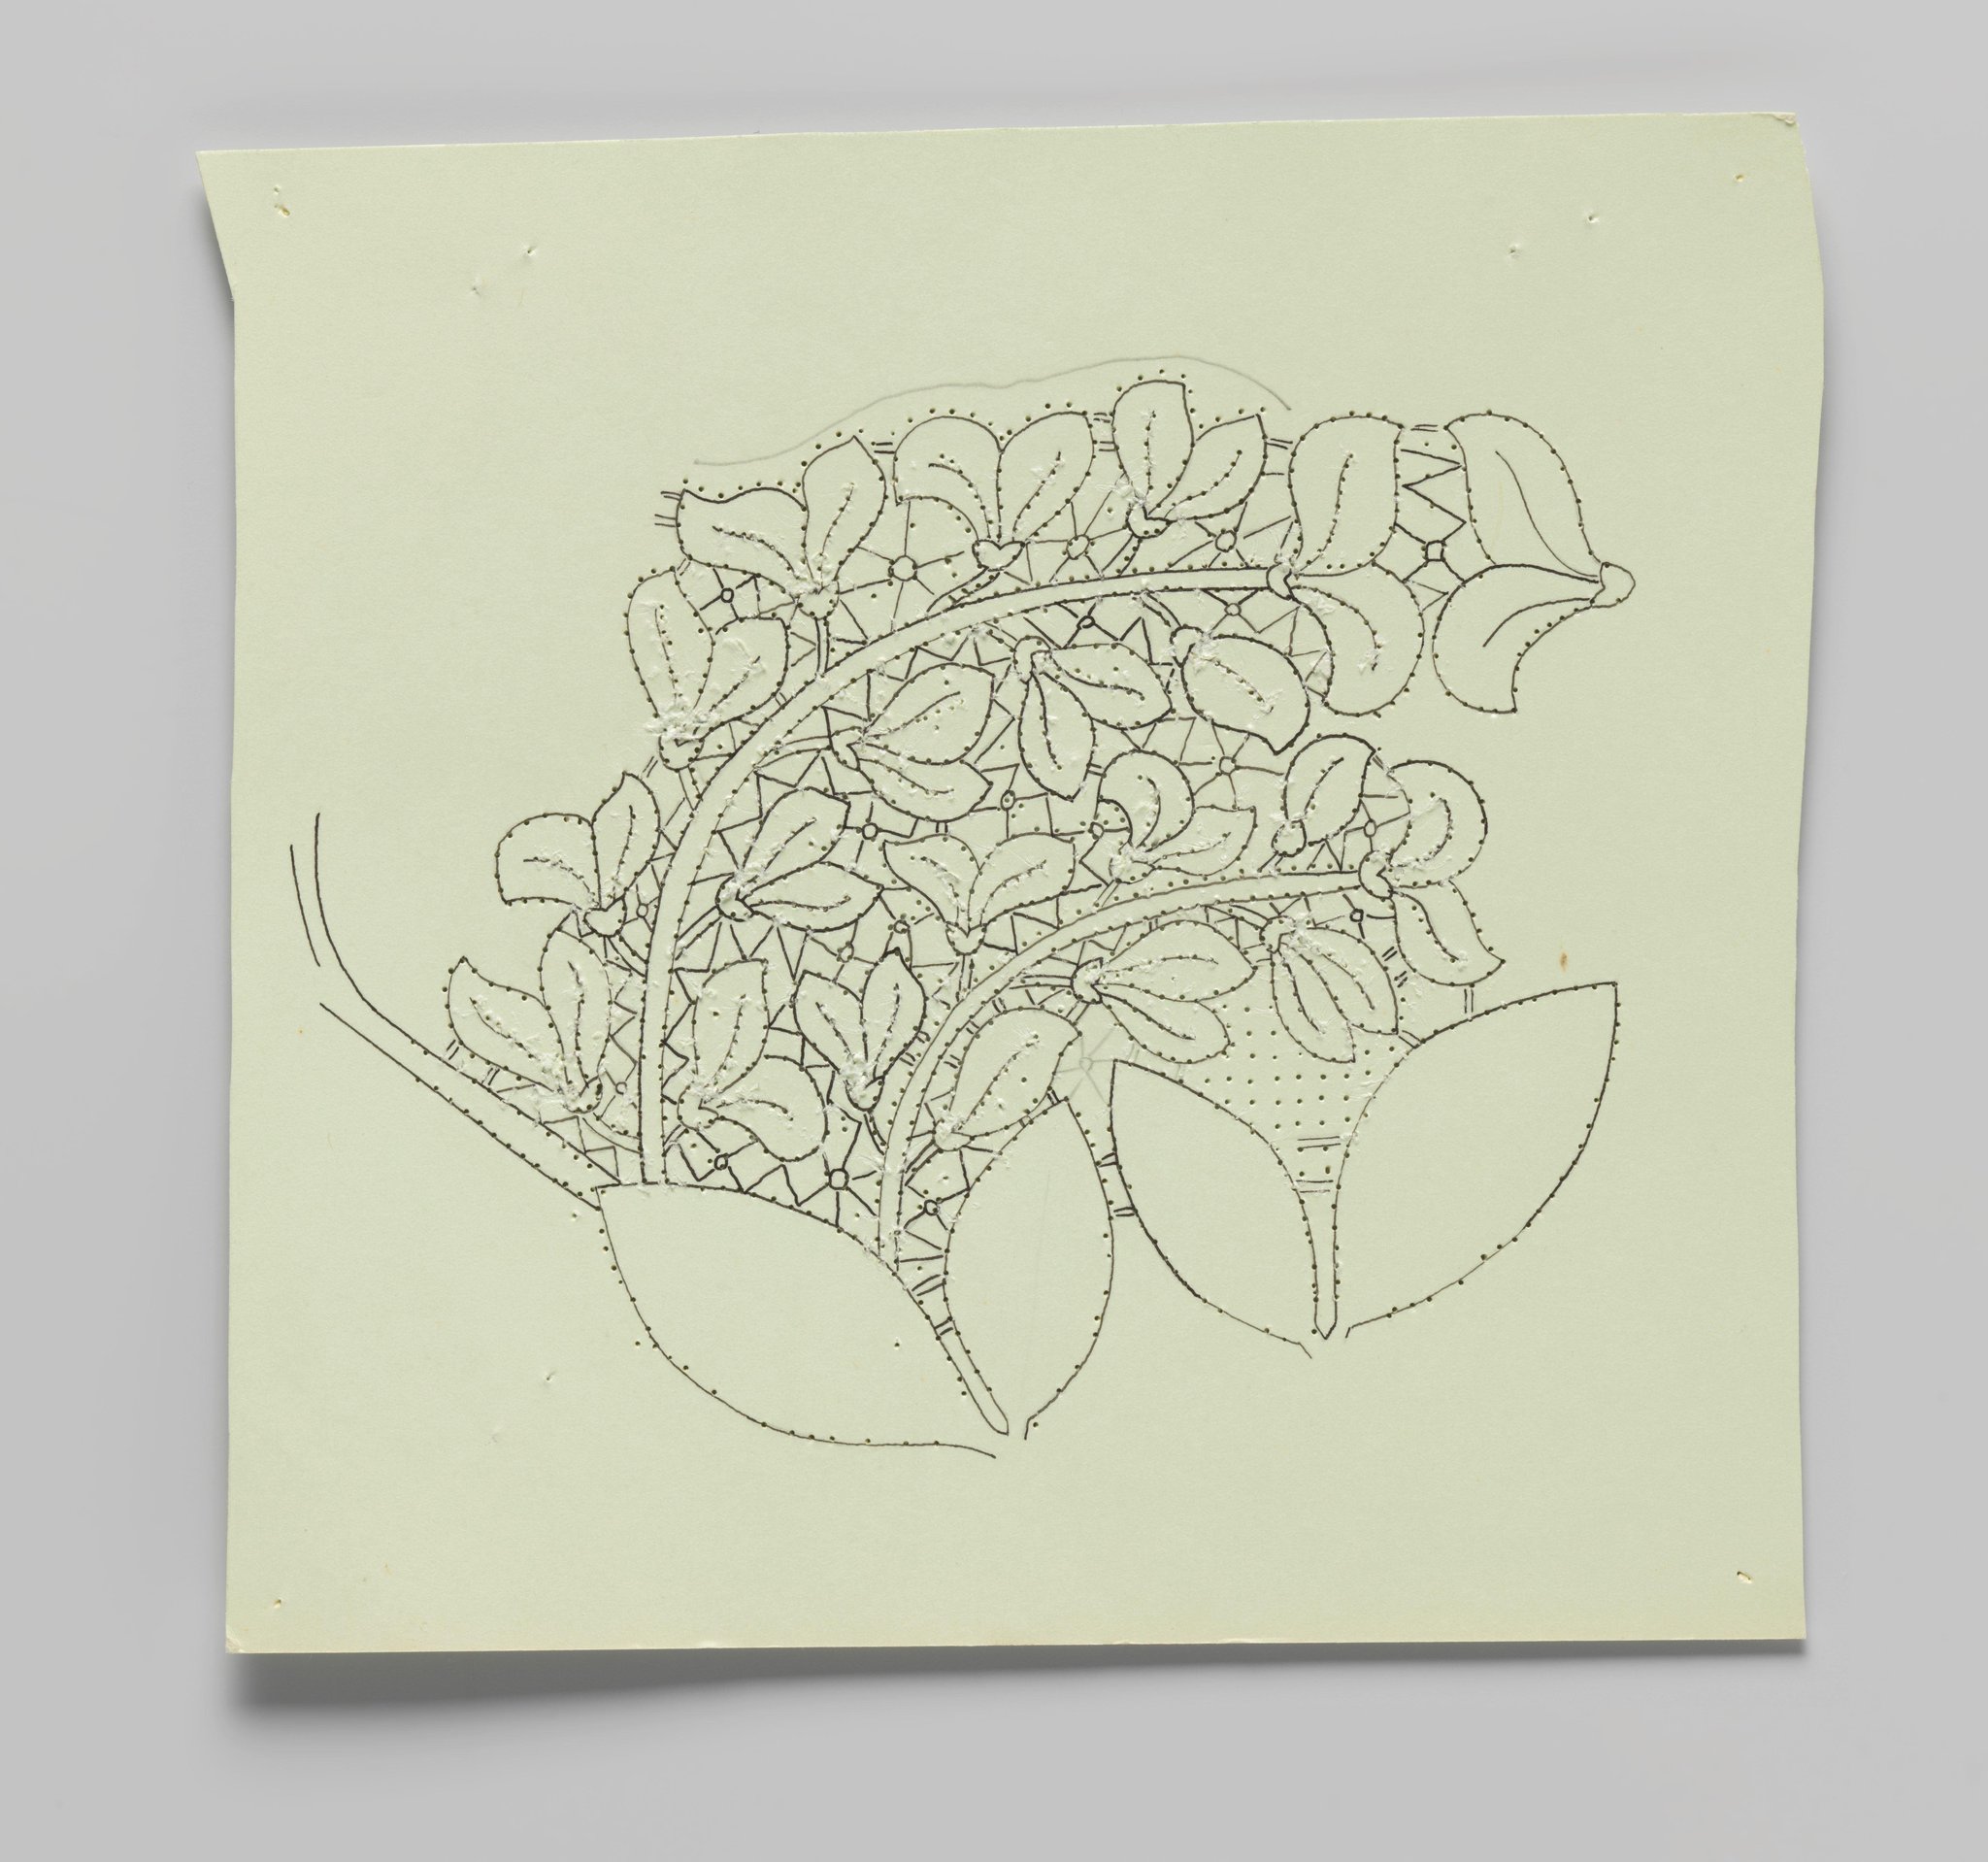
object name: tool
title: Kantpatroon voor een kleed van kloskant met goudenregentakken en -bloemen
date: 1912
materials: paper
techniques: drawing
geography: apeldoorn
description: Kantbrief of kantpatroon met een deel van het patroon voor een kleed met invnr. BK-1979-84.